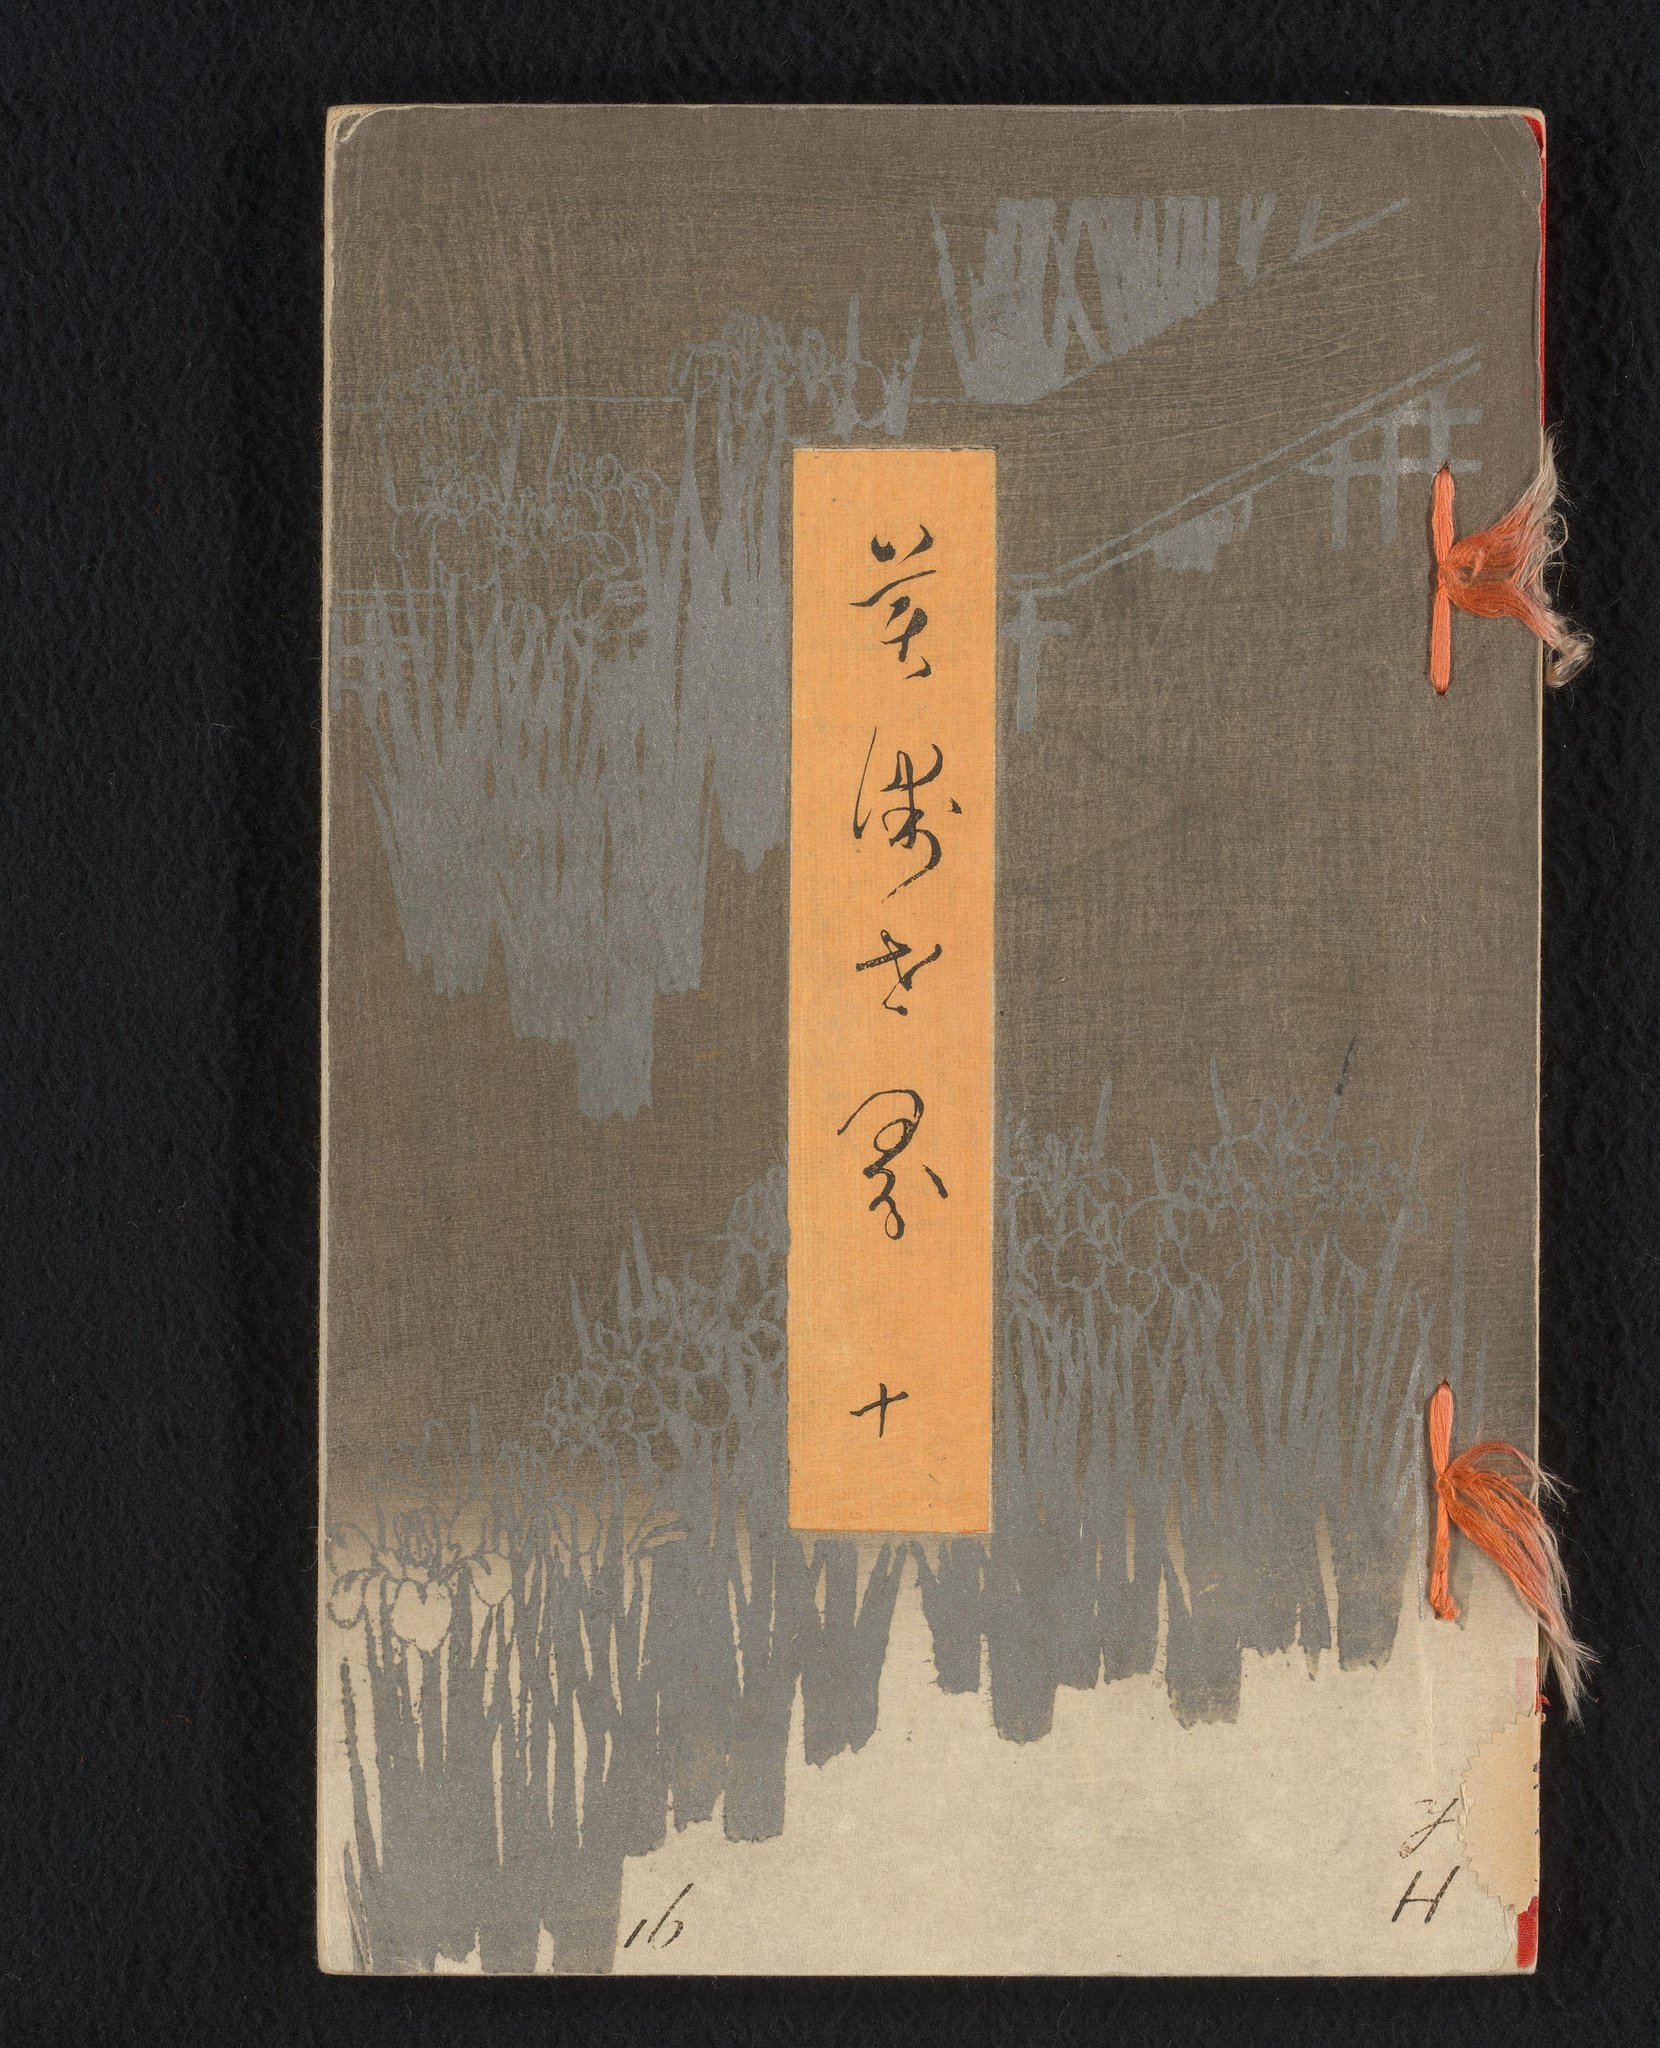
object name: book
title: Wereld der Kunsten - 10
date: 1891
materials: paper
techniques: blind stamped, woodcut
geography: tokyo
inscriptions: collector's mark: ‘Rijksschool voor kunstnijverheid’ Lugt 3937